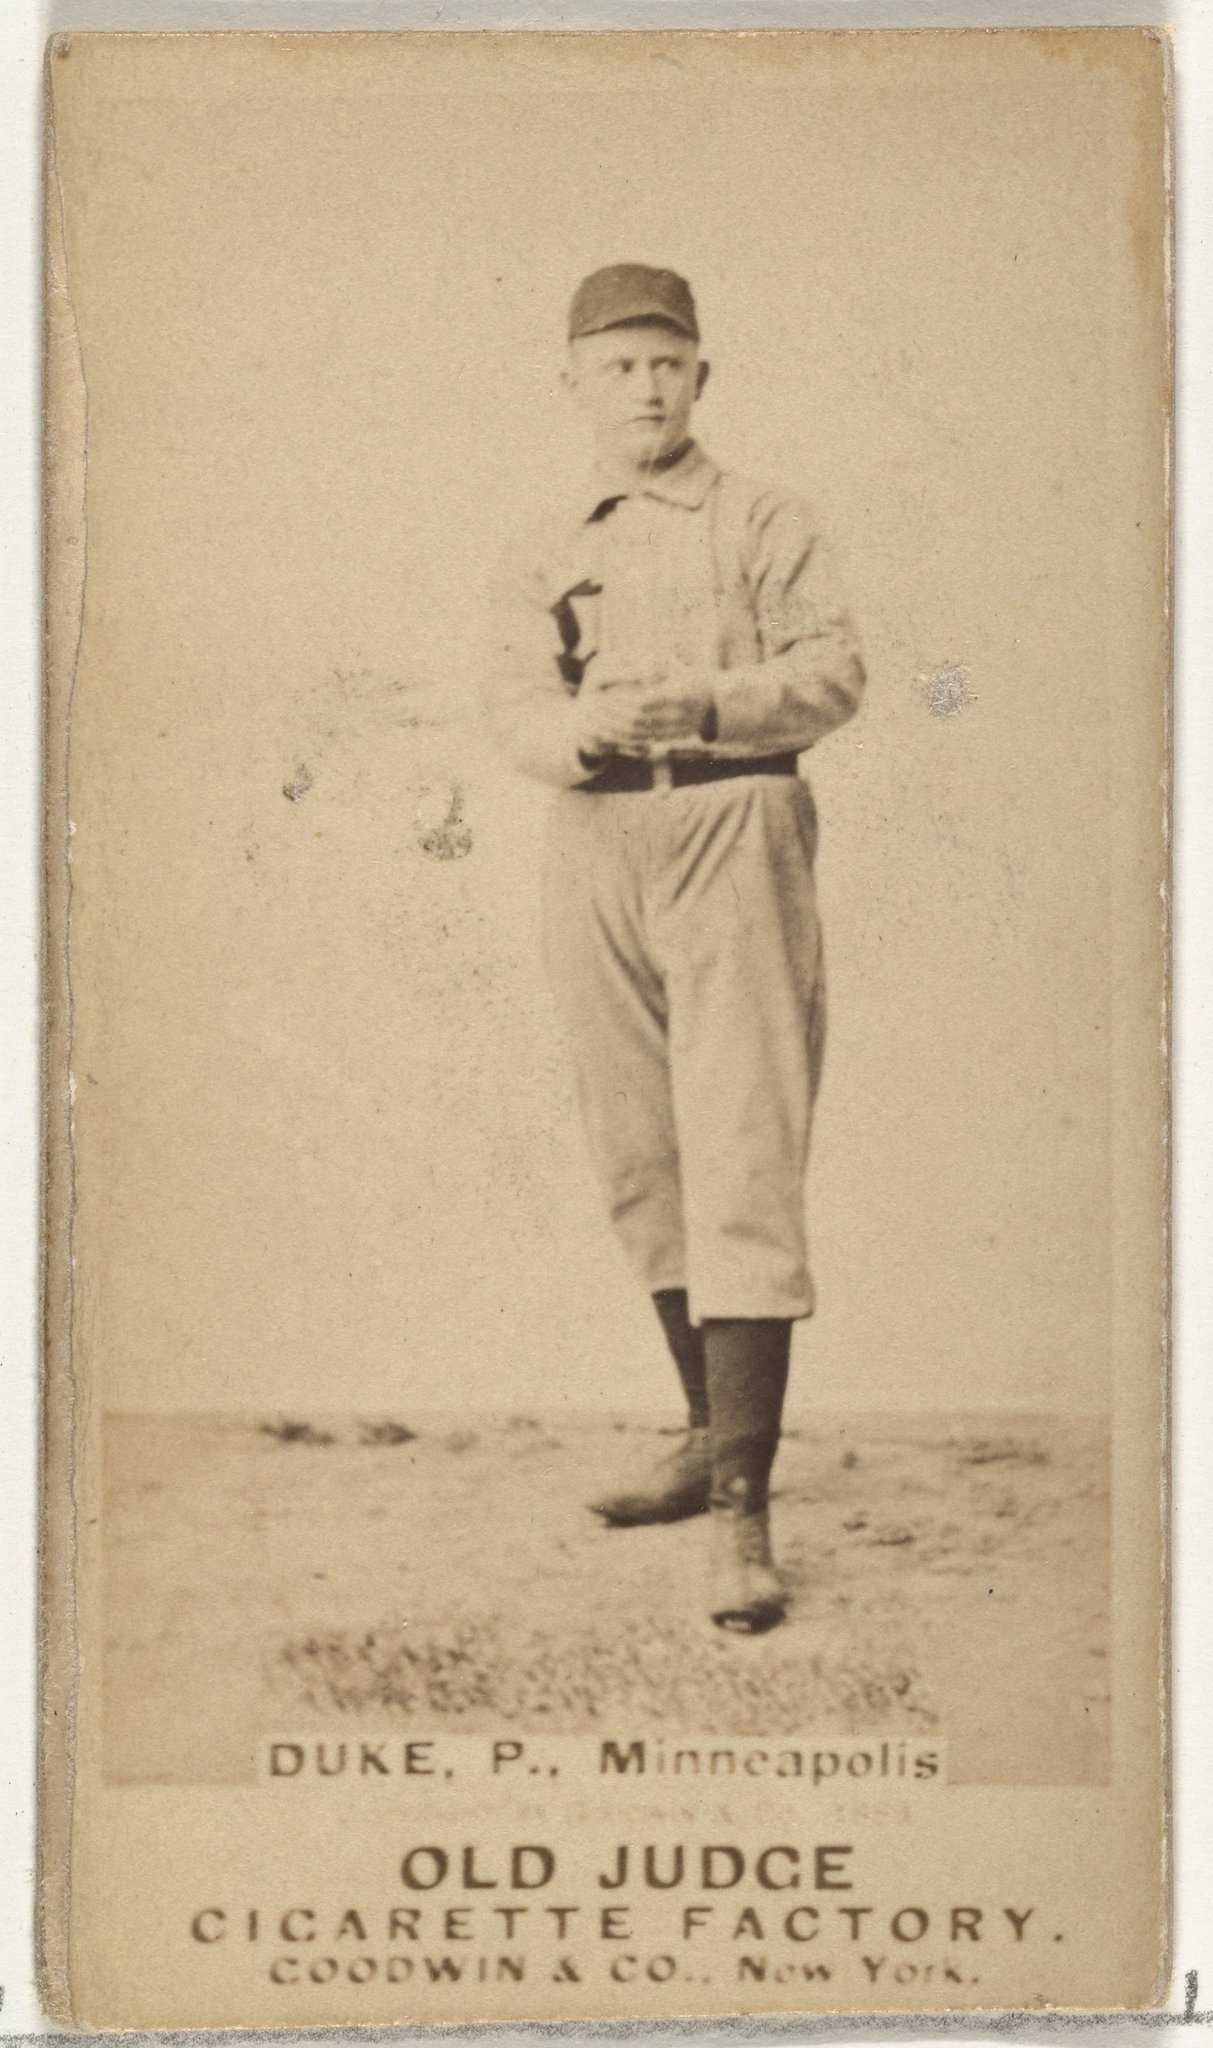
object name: baseball card, photograph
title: Martin F. "Duck" Duke, Pitcher, Minneapolis, from the Old Judge series (N172) for Old Judge Cigarettes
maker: goodwin & company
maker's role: publisher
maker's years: 1850-1950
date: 1888-1889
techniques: albumen silver print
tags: men,portraits,baseball,athletes